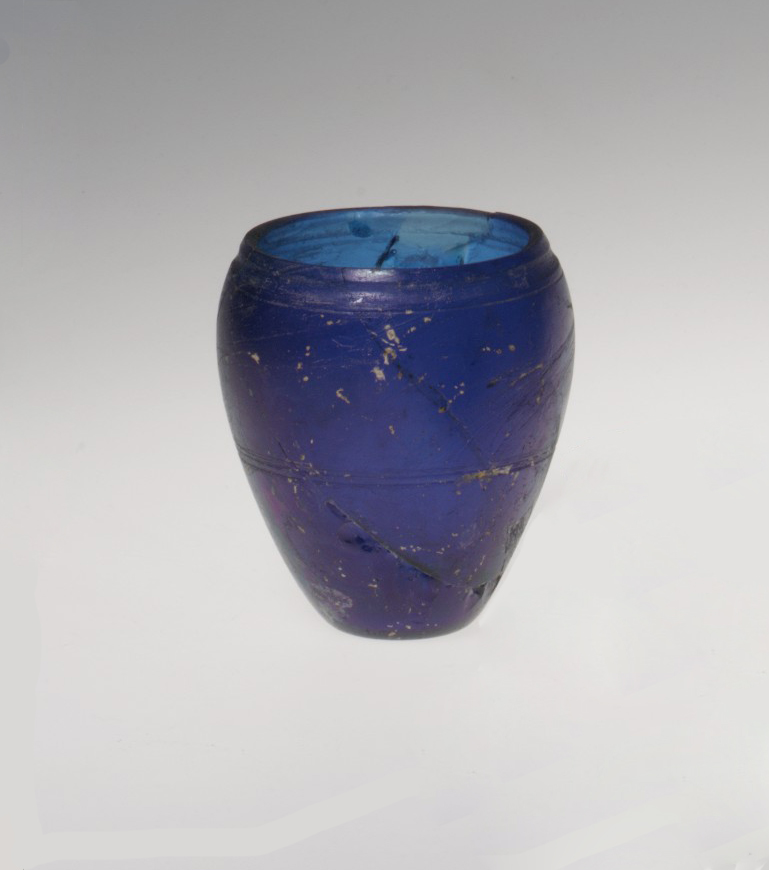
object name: beaker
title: Glass beaker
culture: roman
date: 1-33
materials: glass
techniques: casting